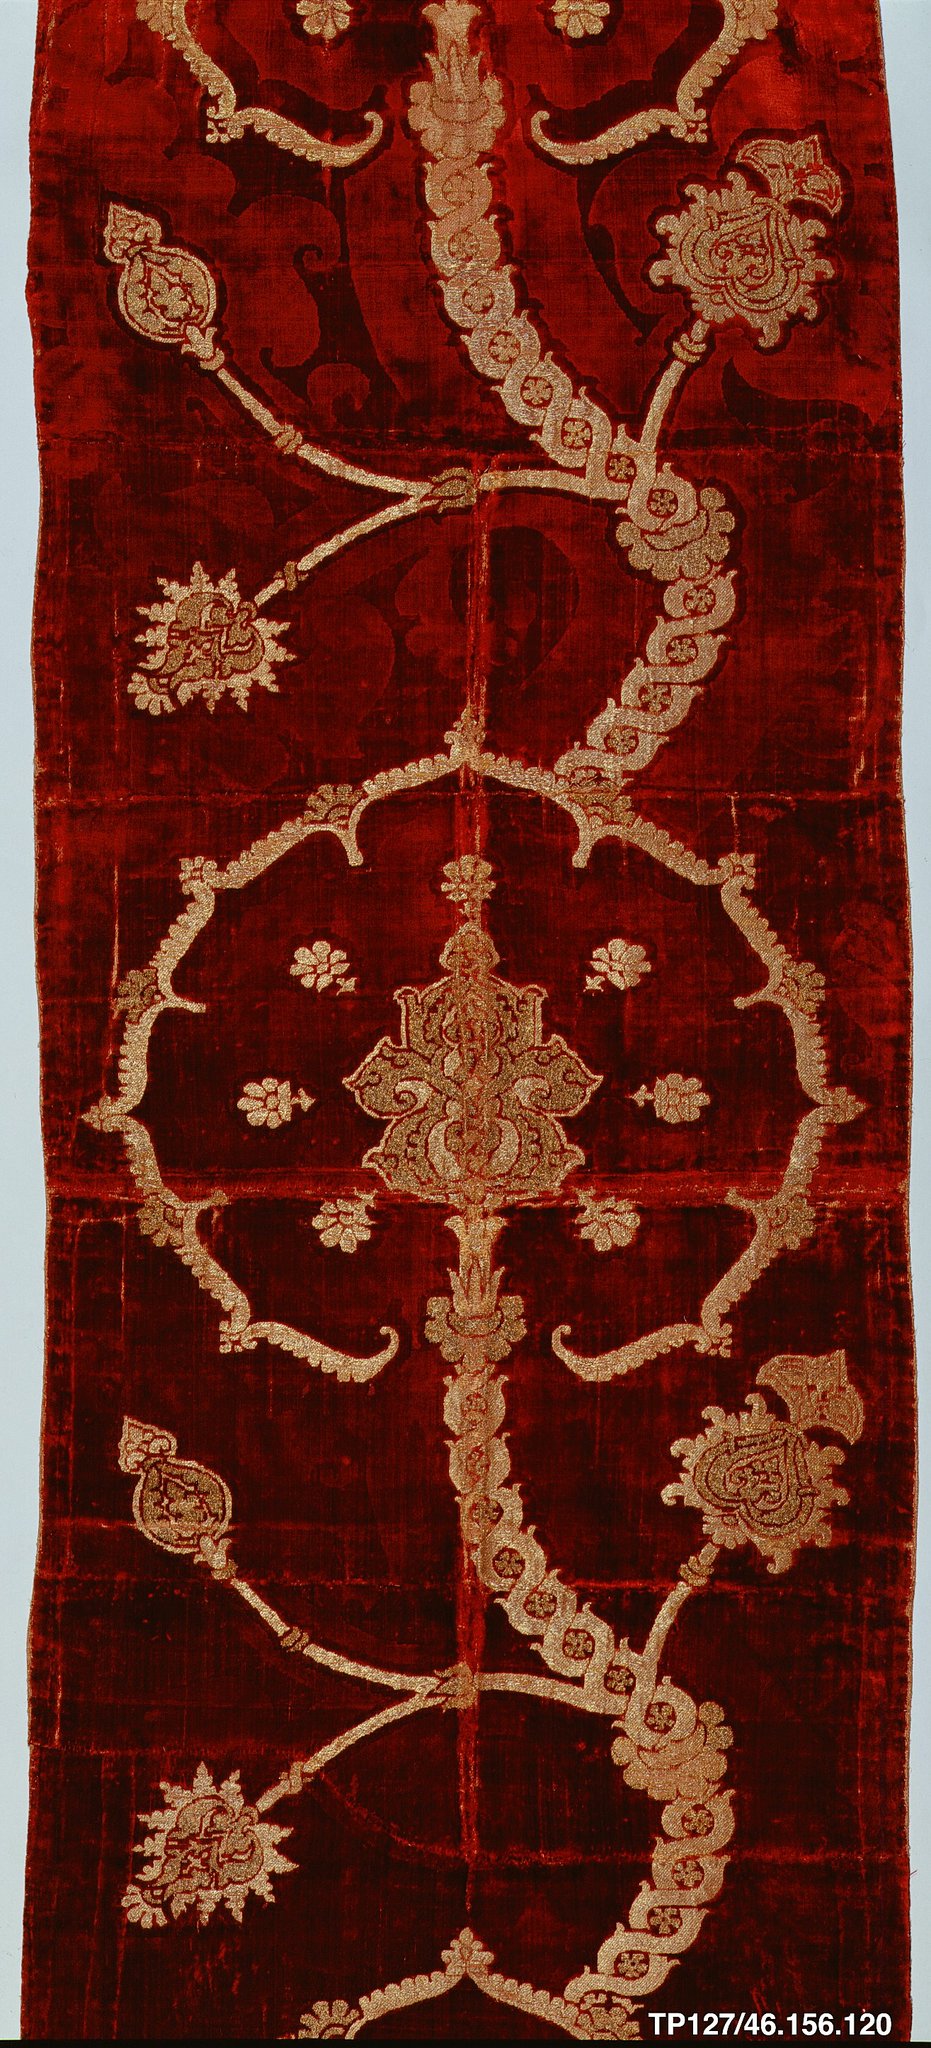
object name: length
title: Length of velvet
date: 1501-1600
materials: gold, metal thread, silk, velvet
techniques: brocade, cutting, voiding